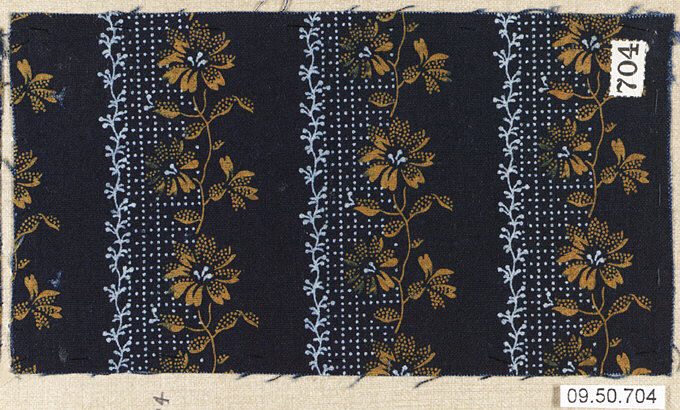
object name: piece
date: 1801-1900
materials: cotton